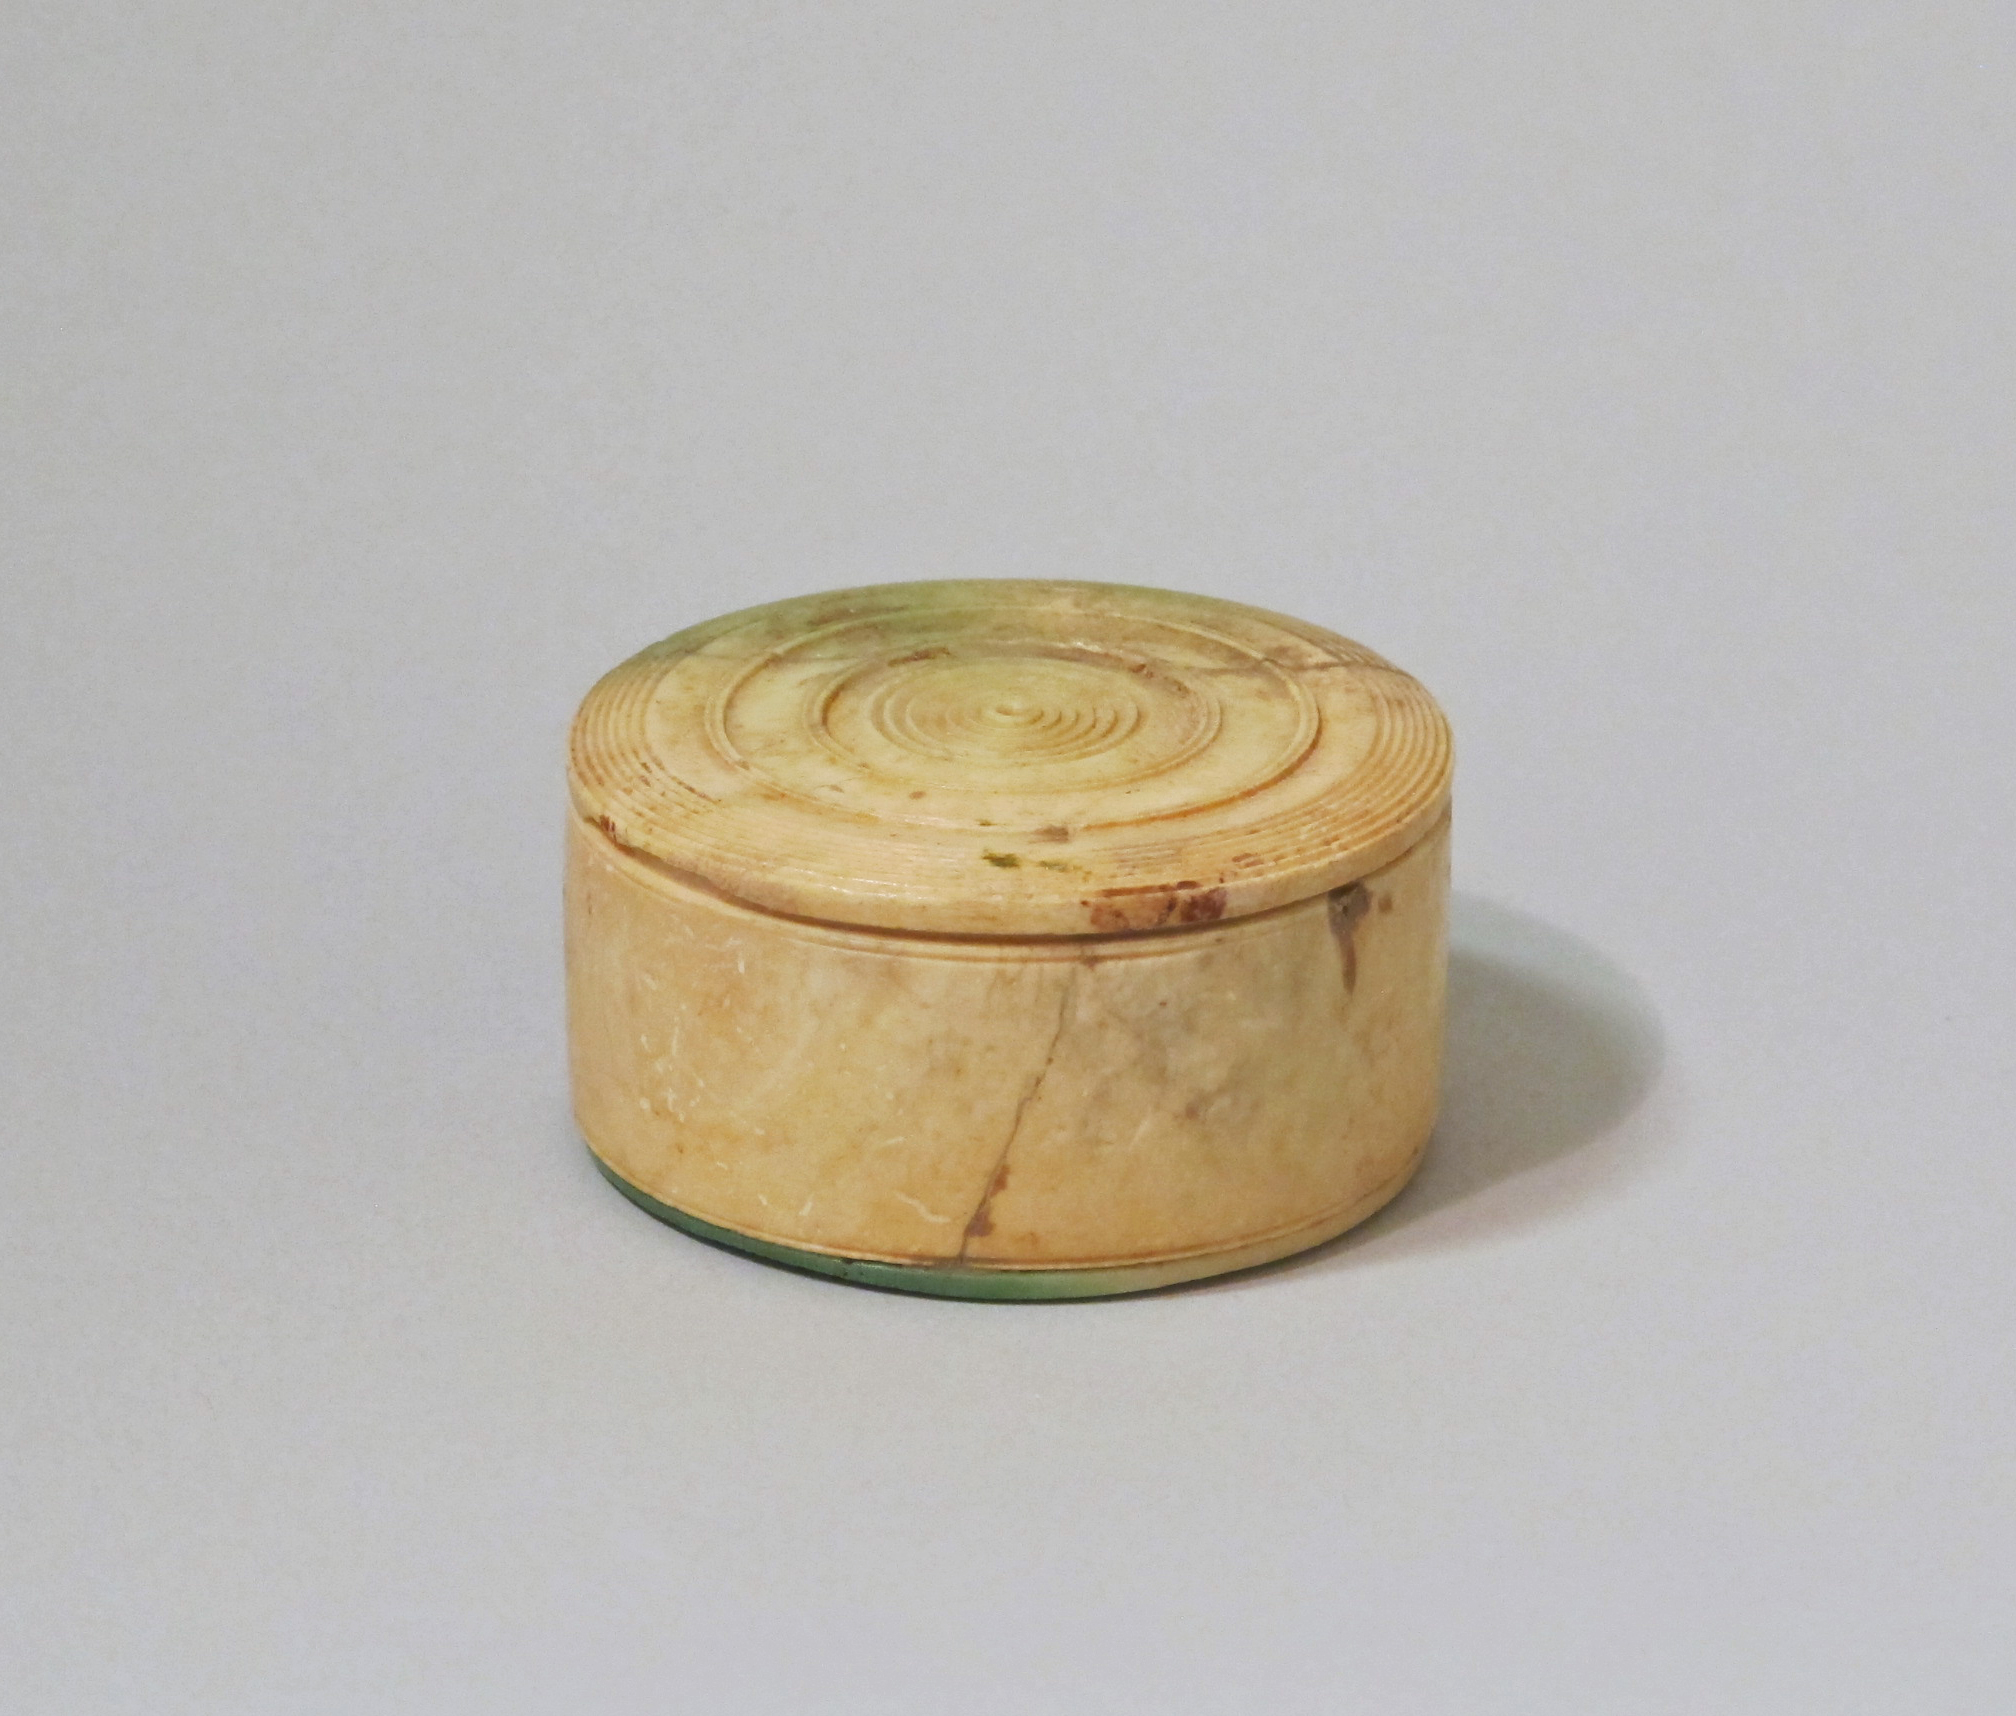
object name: pyxis with lid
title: Bone pyxis (box with lid)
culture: roman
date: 1-50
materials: bone